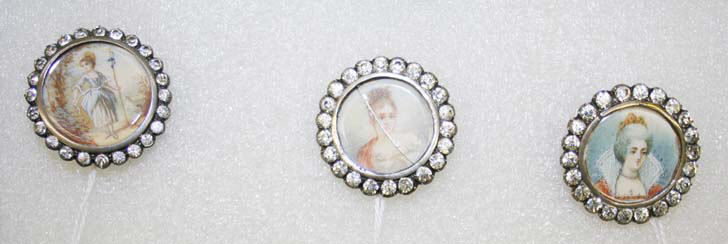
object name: button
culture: french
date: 1775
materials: ivory, metal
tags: women